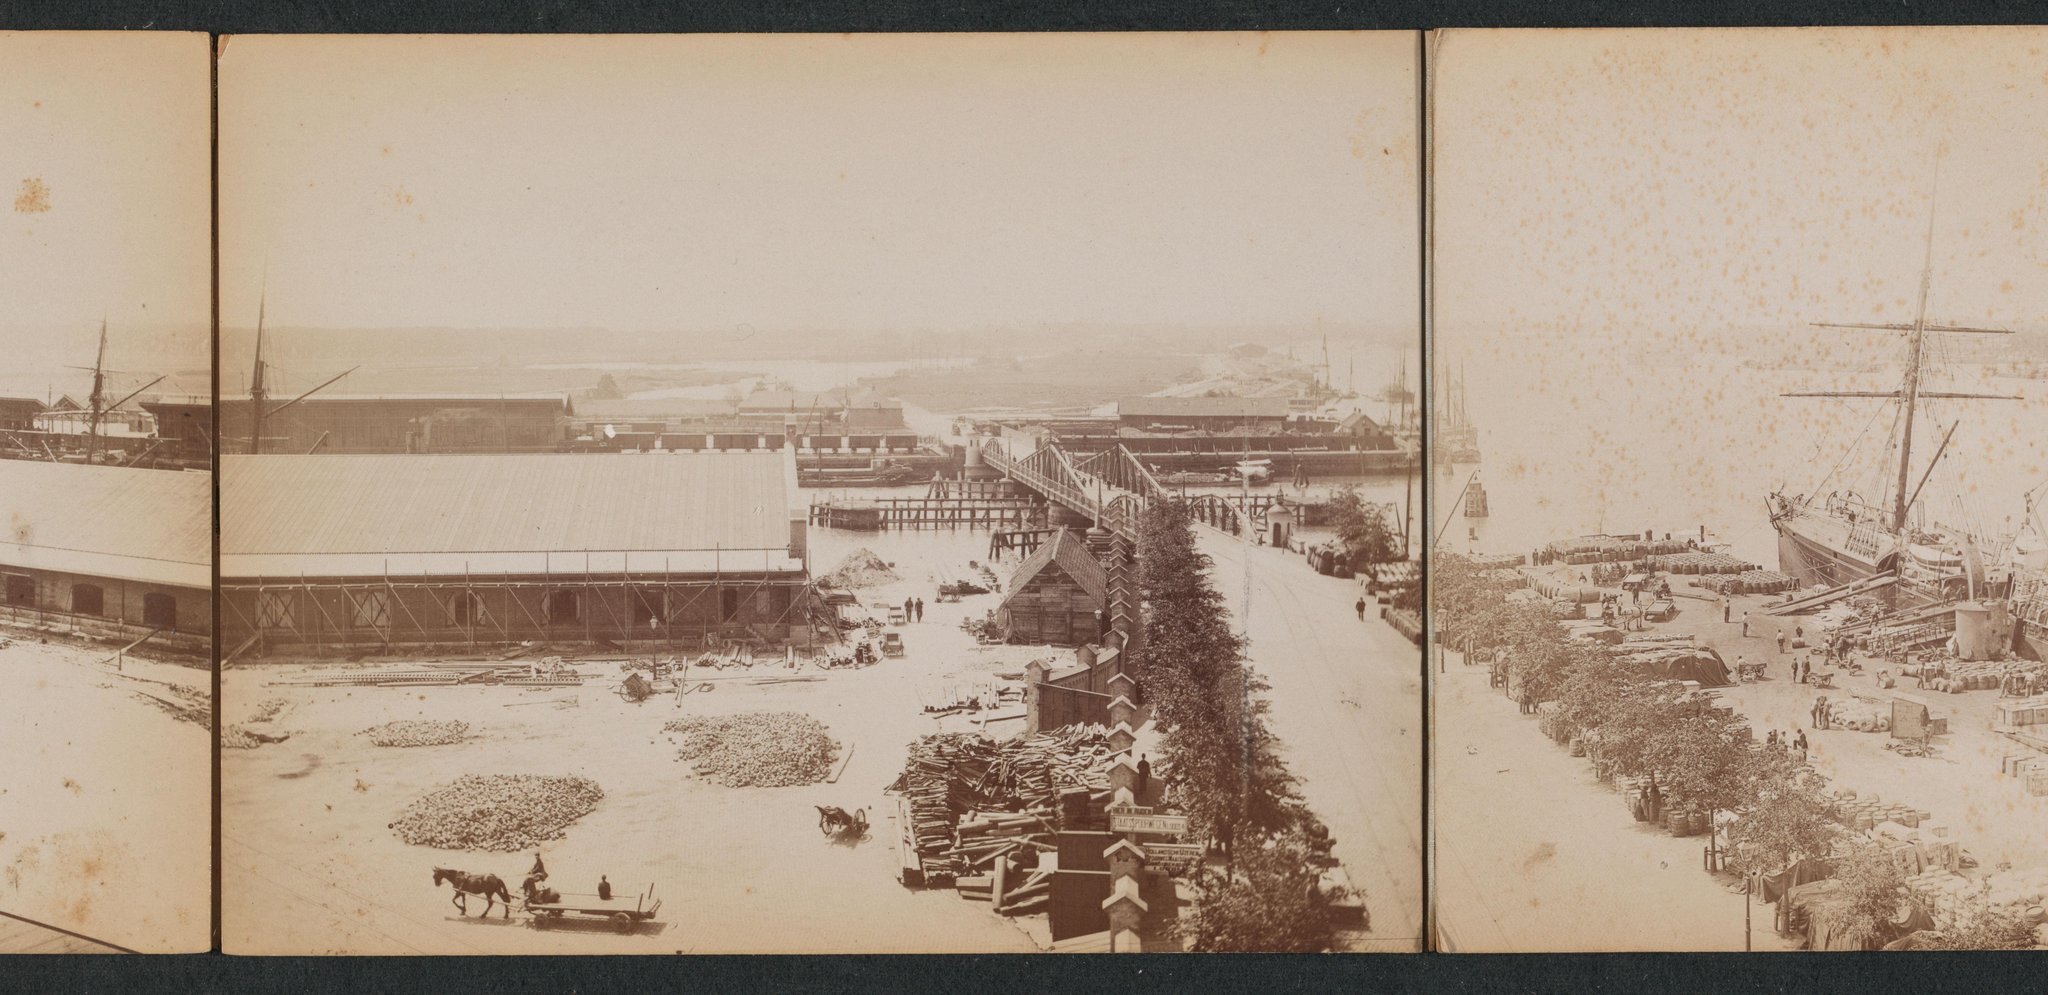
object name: photograph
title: Gezicht op het haventerrein bij de brug over de Spoorweghaven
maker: f. von pöppinghausen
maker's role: fotograaf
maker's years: 1851-1905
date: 1878-1900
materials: cardboard, paper, photographic support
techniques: albumen print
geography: rotterdam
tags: harbour, warehouse (~ harbour), four-wheeled, animal-drawn vehicle, e.g.: cab, carriage, coach (+ conveyance for transport of persons), river, river bank, pier, quay, wharf, bridge in city across river, canal, etc., prospect of city, town panorama, silhouette of city, steamship, motorship, rotterdam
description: Onderdeel van Panorama van de Rotterdamse haventerreinen op de Kop van Zuid, foto 6 van 7.